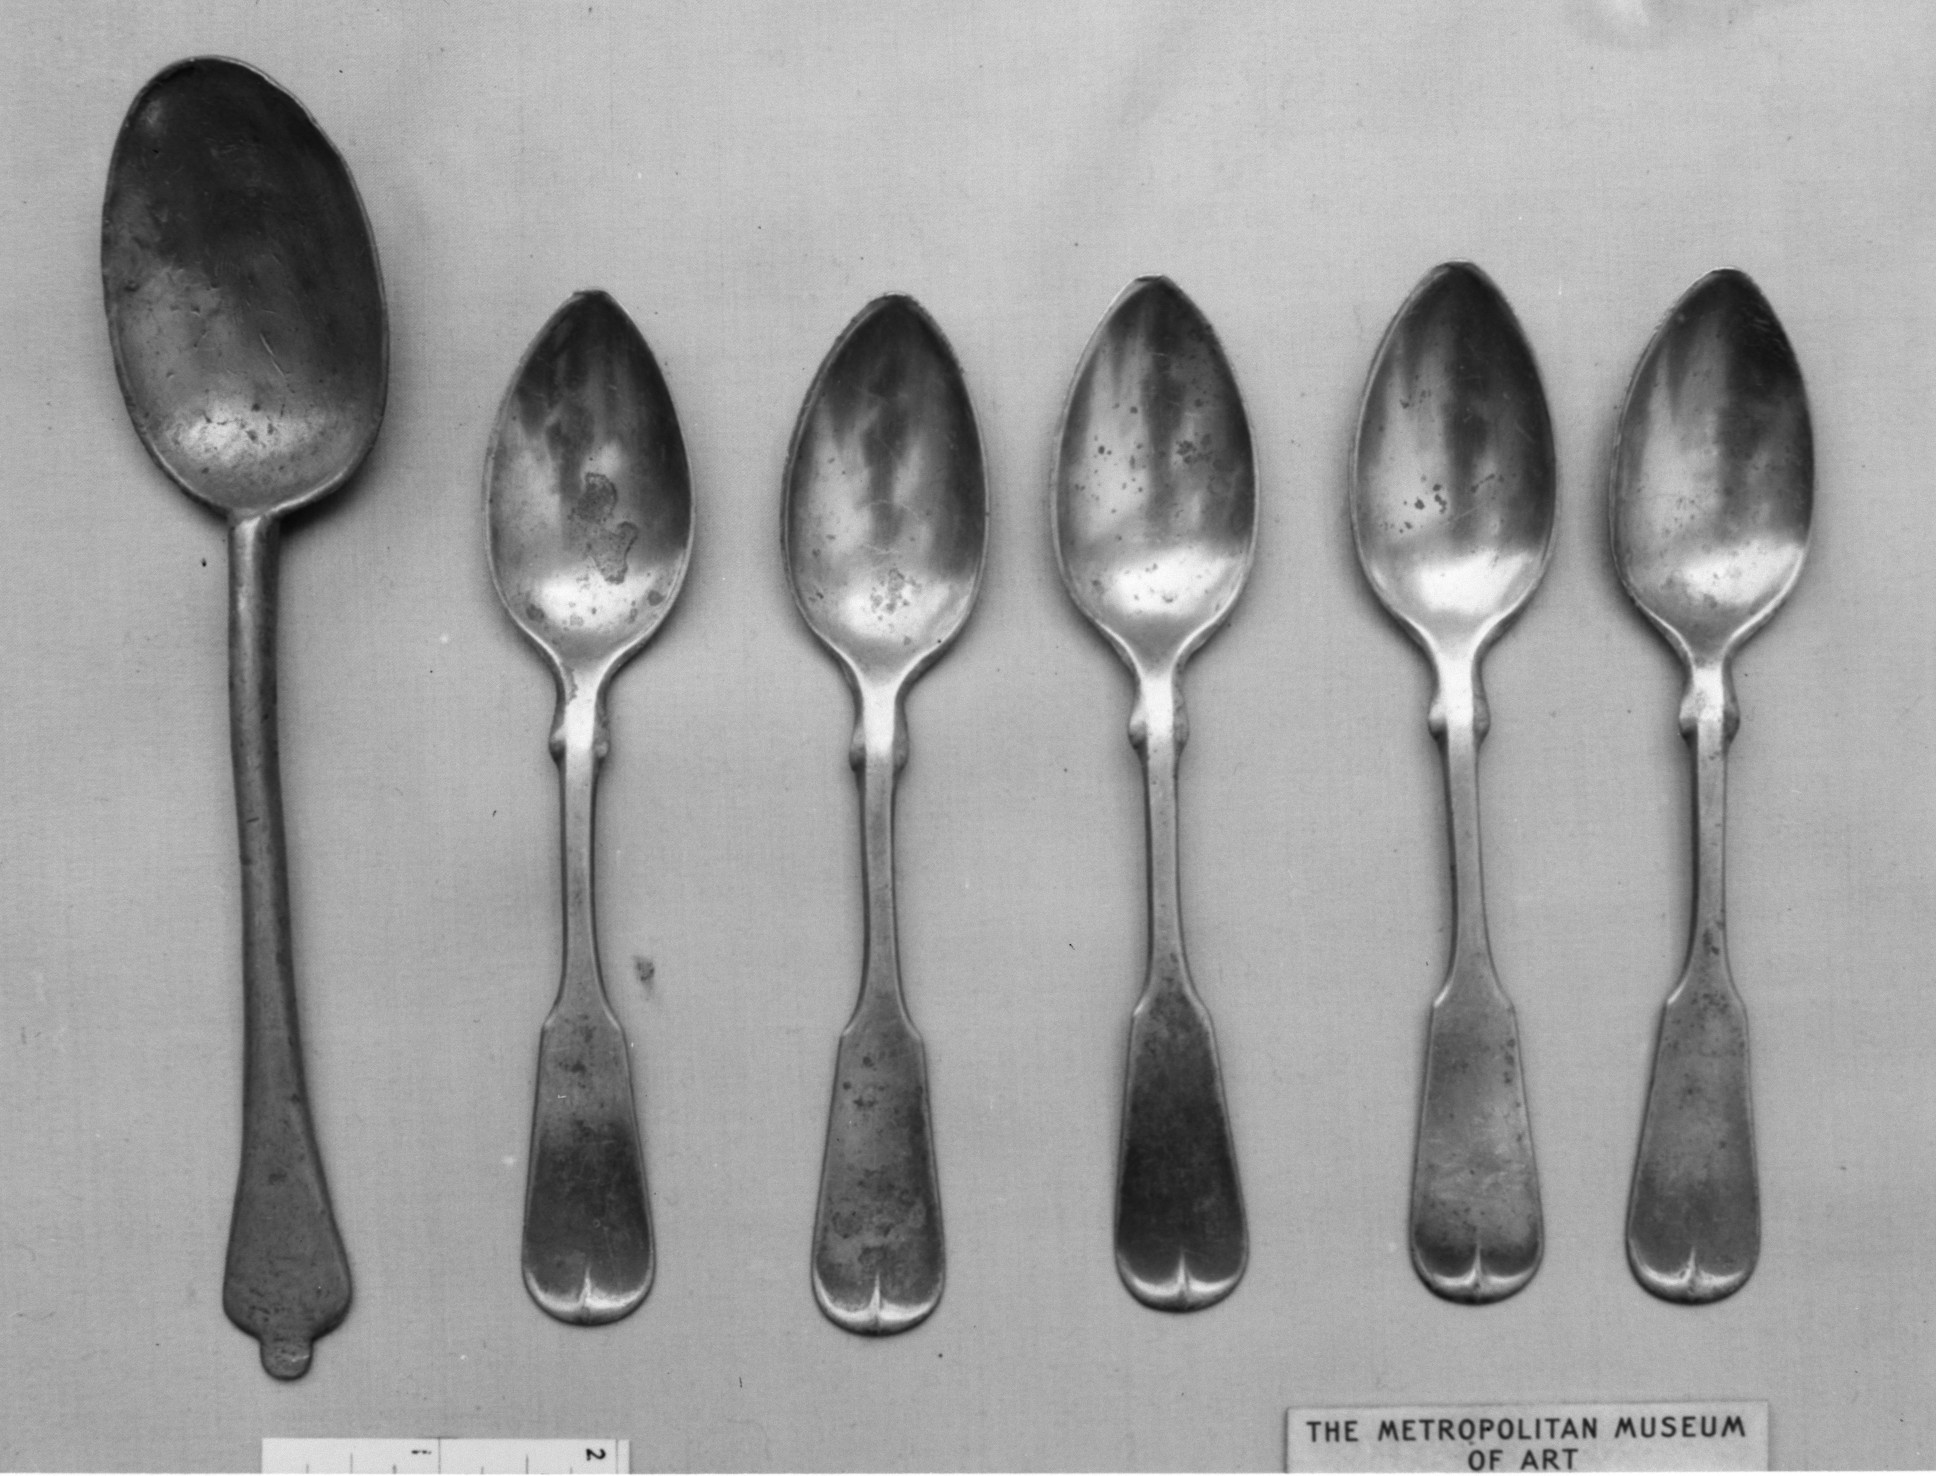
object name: spoon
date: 1651-1700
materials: pewter